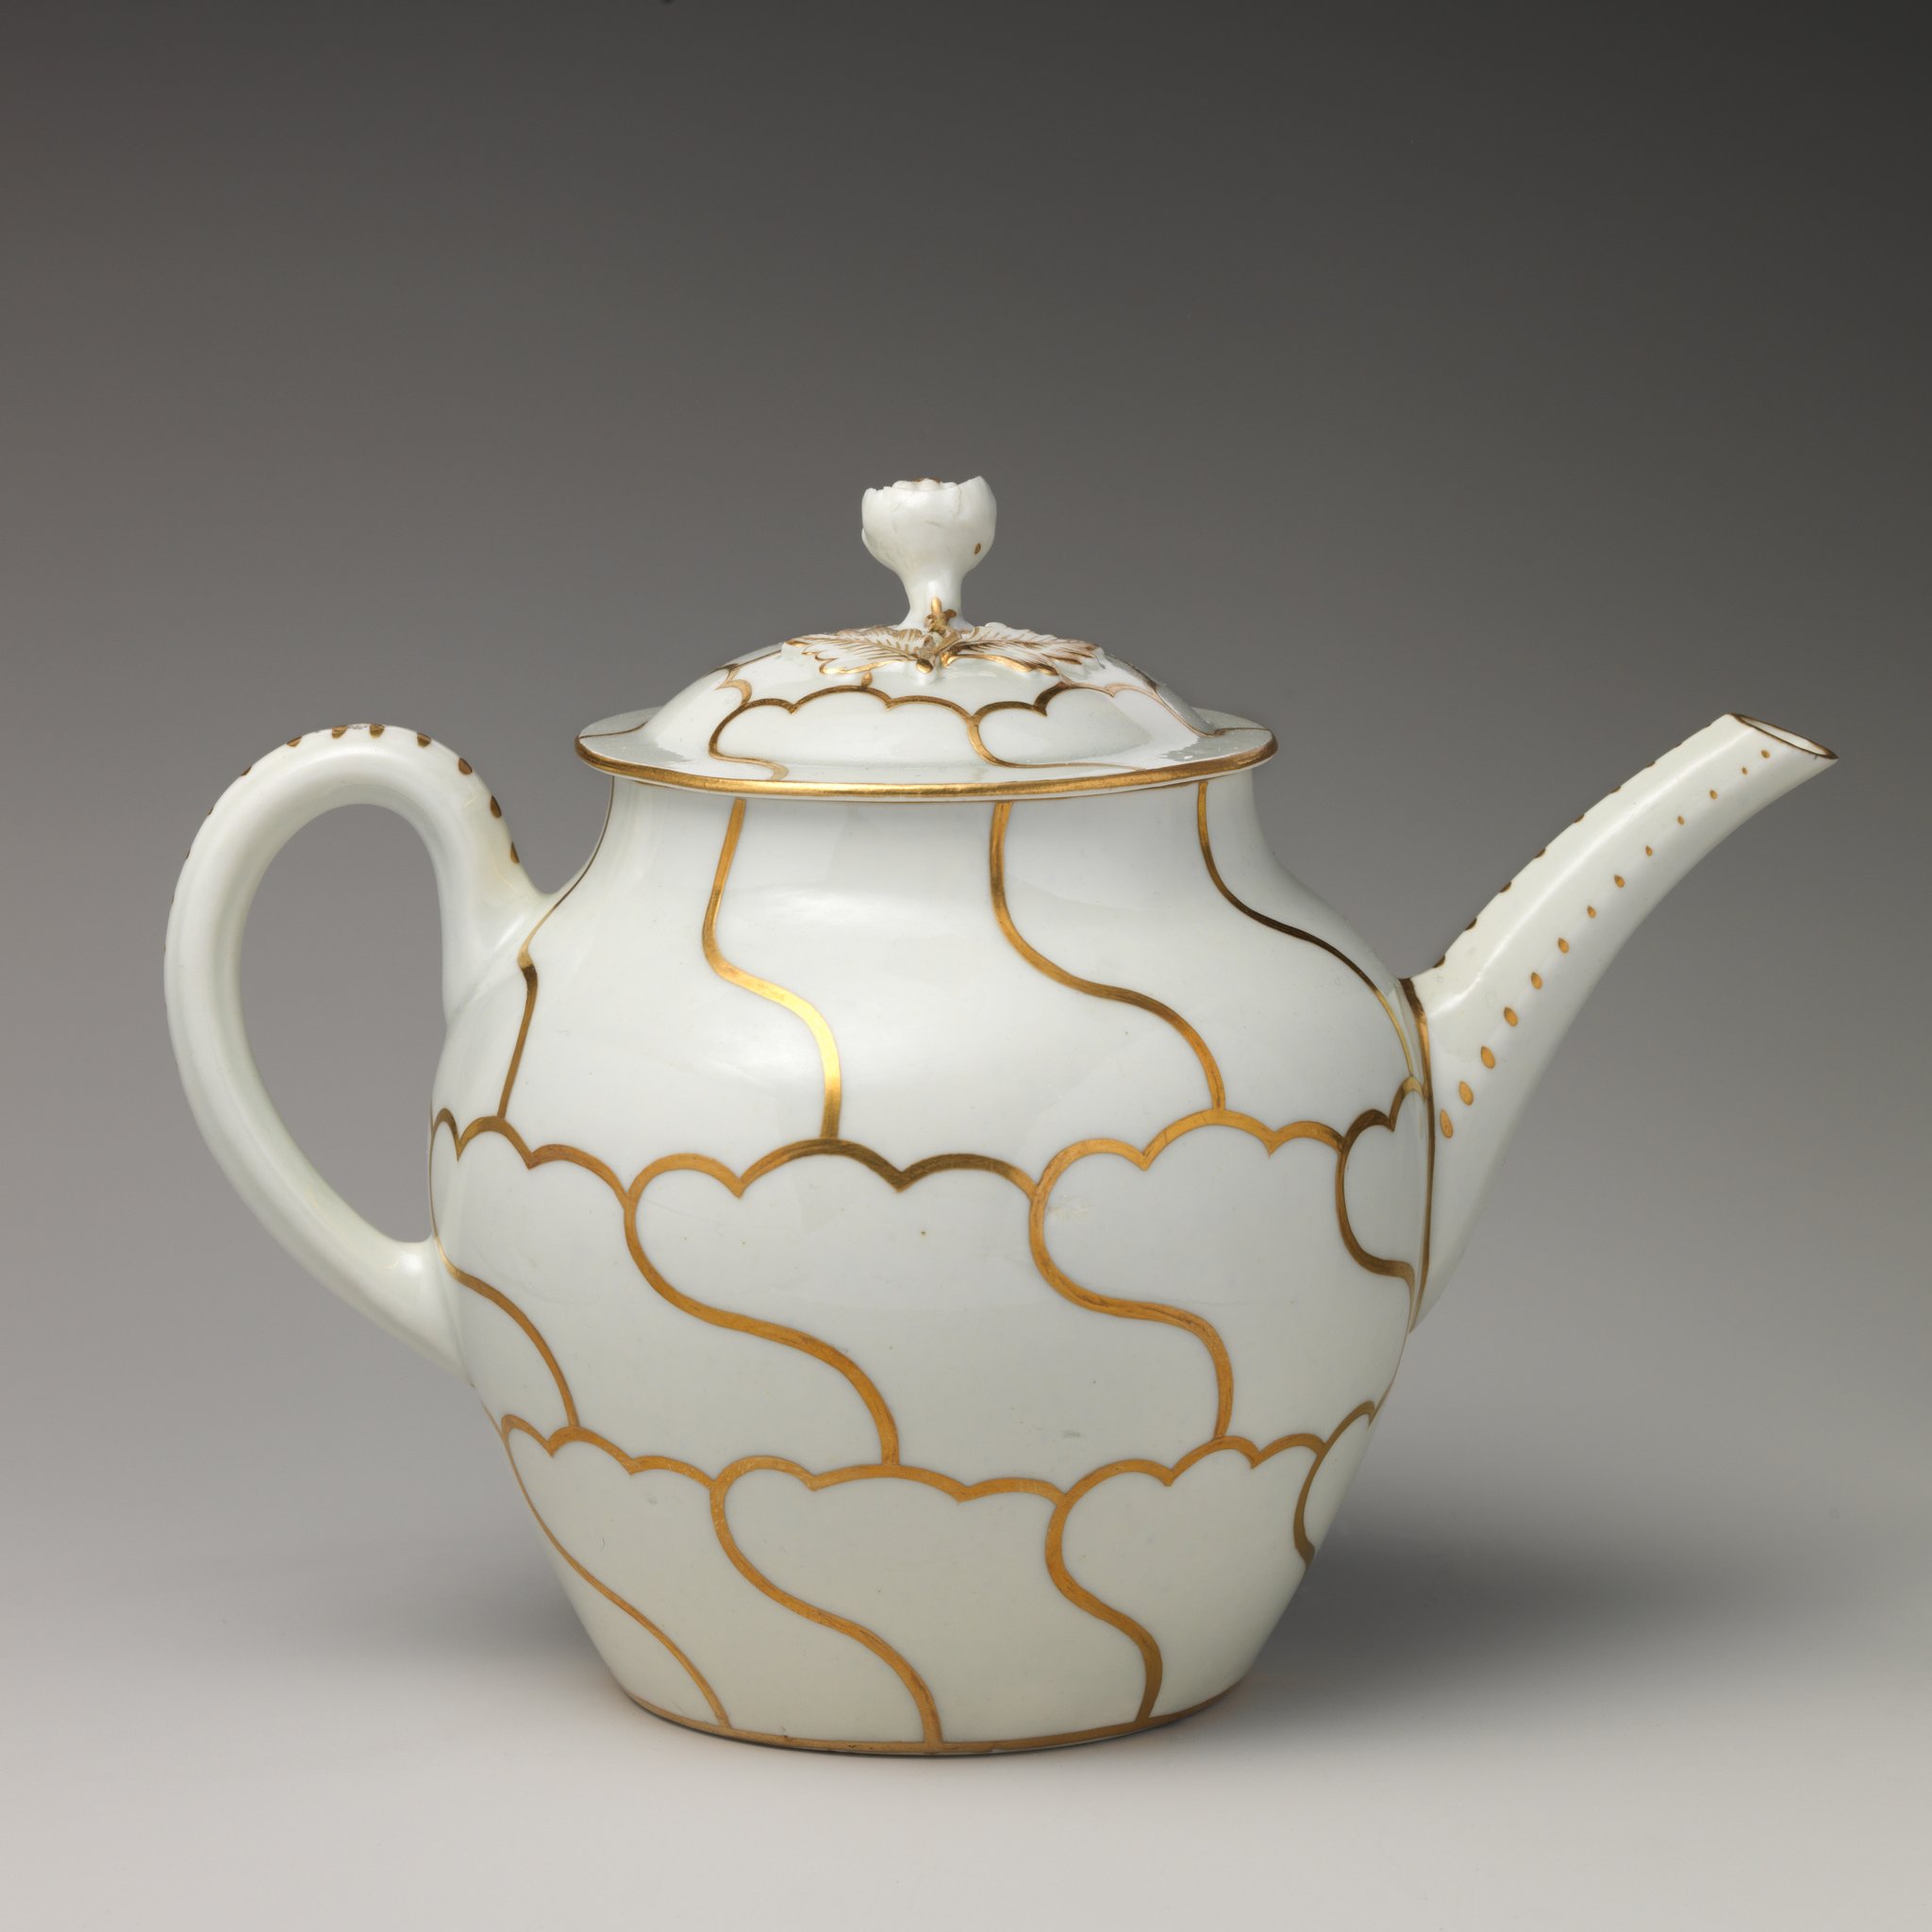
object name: teapot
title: Teapot (part of a service)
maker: worcester factory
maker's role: factory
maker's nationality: british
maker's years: 1751-2008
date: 1775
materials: soft paste porcelain